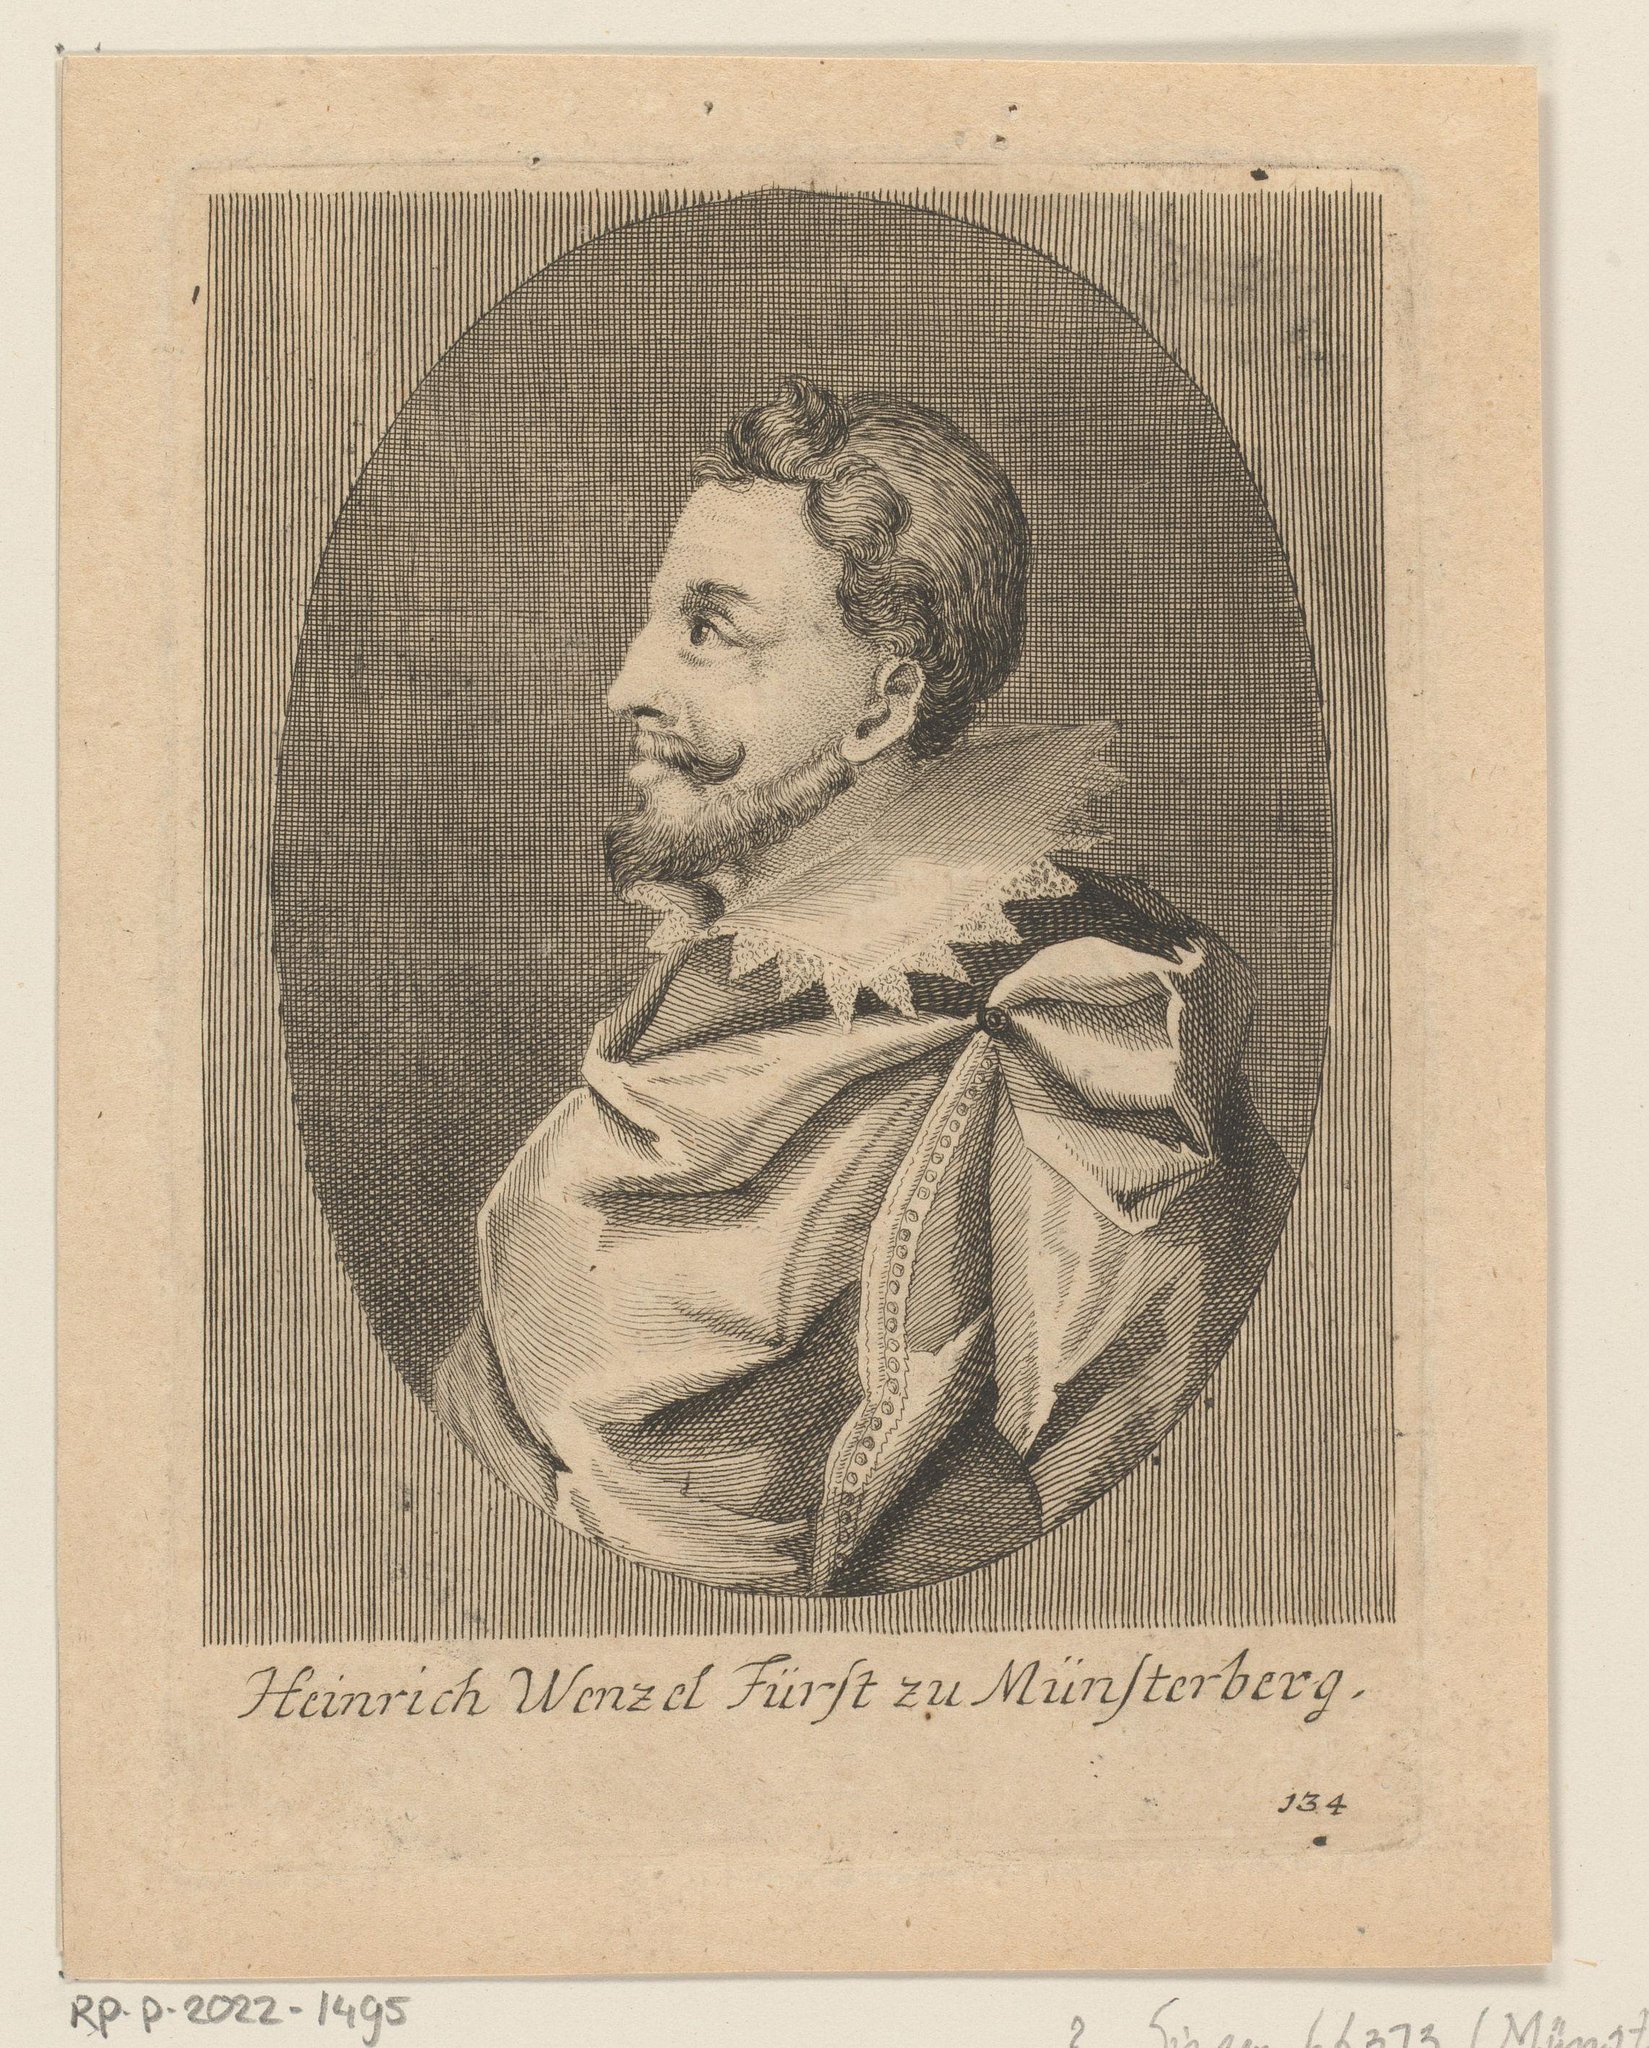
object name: print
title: Heinrich Wenzel fürst zu Münsterberg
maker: Anonymous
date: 1617-1750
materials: paper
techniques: engraving, etching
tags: historical persons